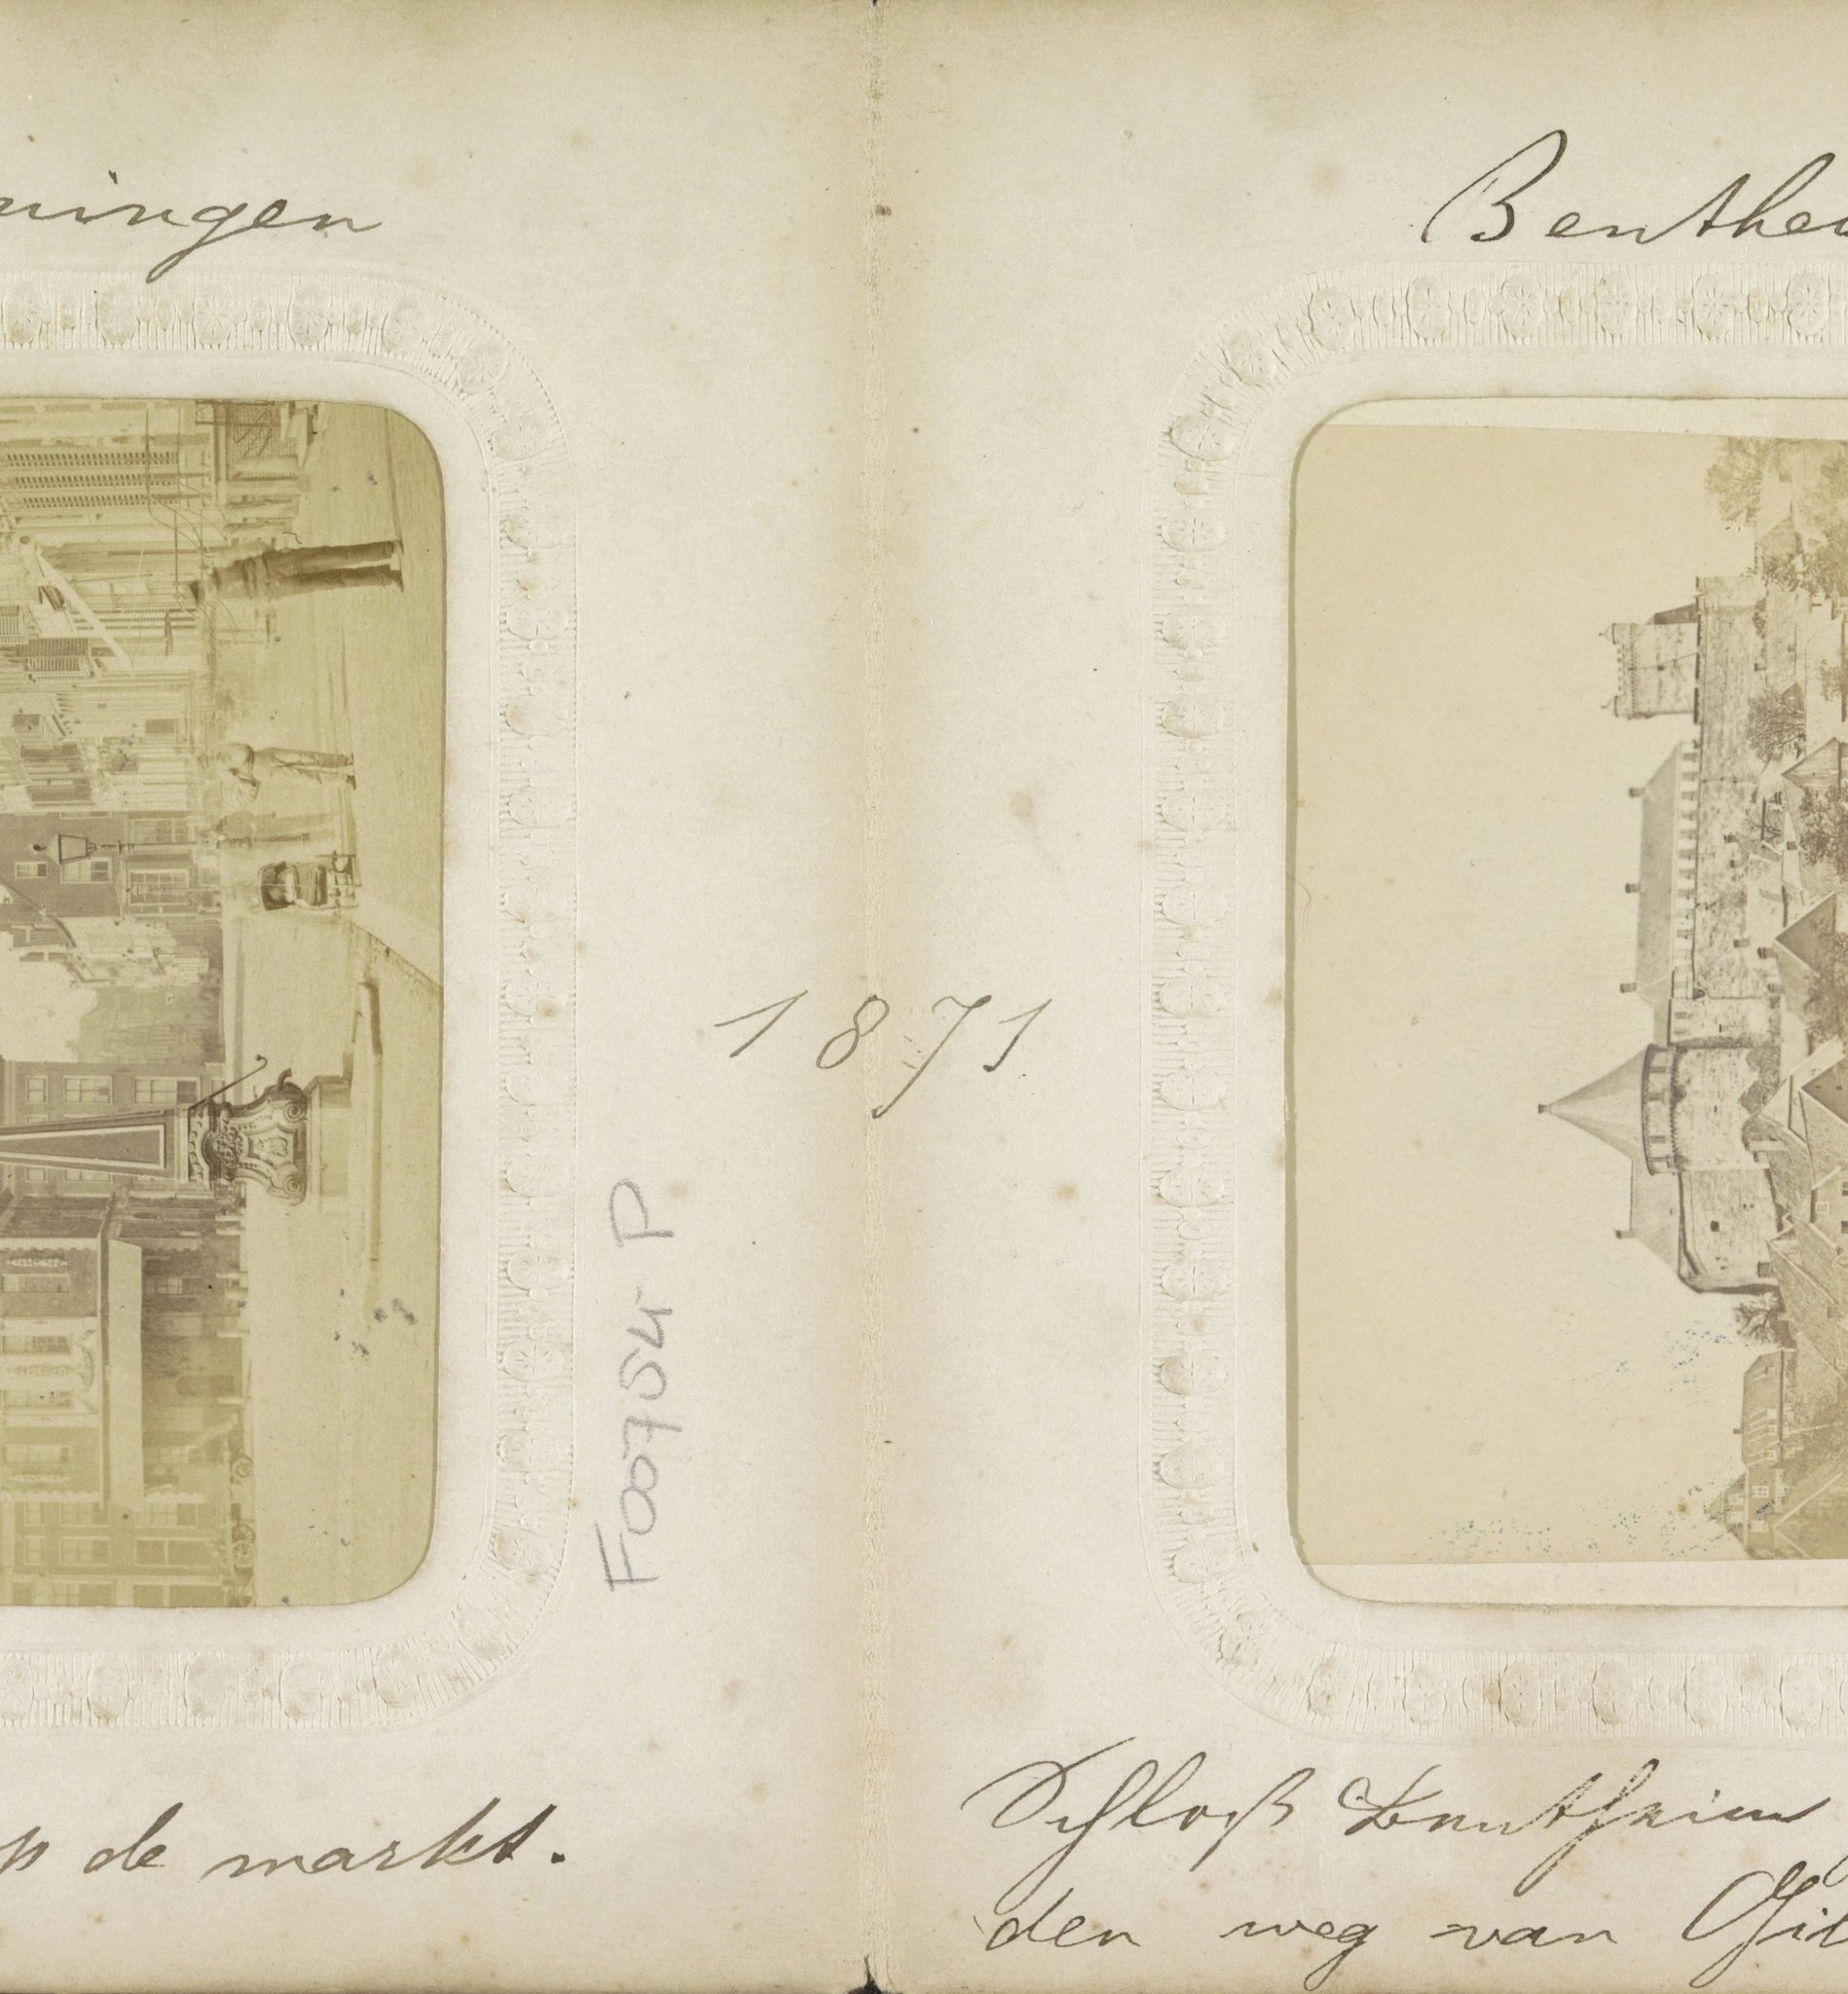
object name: carte de visite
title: Schloss Bentheim gezien van den weg van Gildhausen naar B.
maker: fritz hüsig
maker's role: fotograaf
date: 1871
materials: cardboard, paper, photographic support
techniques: albumen print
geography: bad bentheim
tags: castle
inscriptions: name: ‘Fritz Hüsig Hannover’, name: ‘Egbert de Vries’, name: ‘C.F. Meyer Bentheim’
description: Onderdeel van Fotoalbum met bezienswaardigheden in Nederlandse, Belgische en Duitse steden.